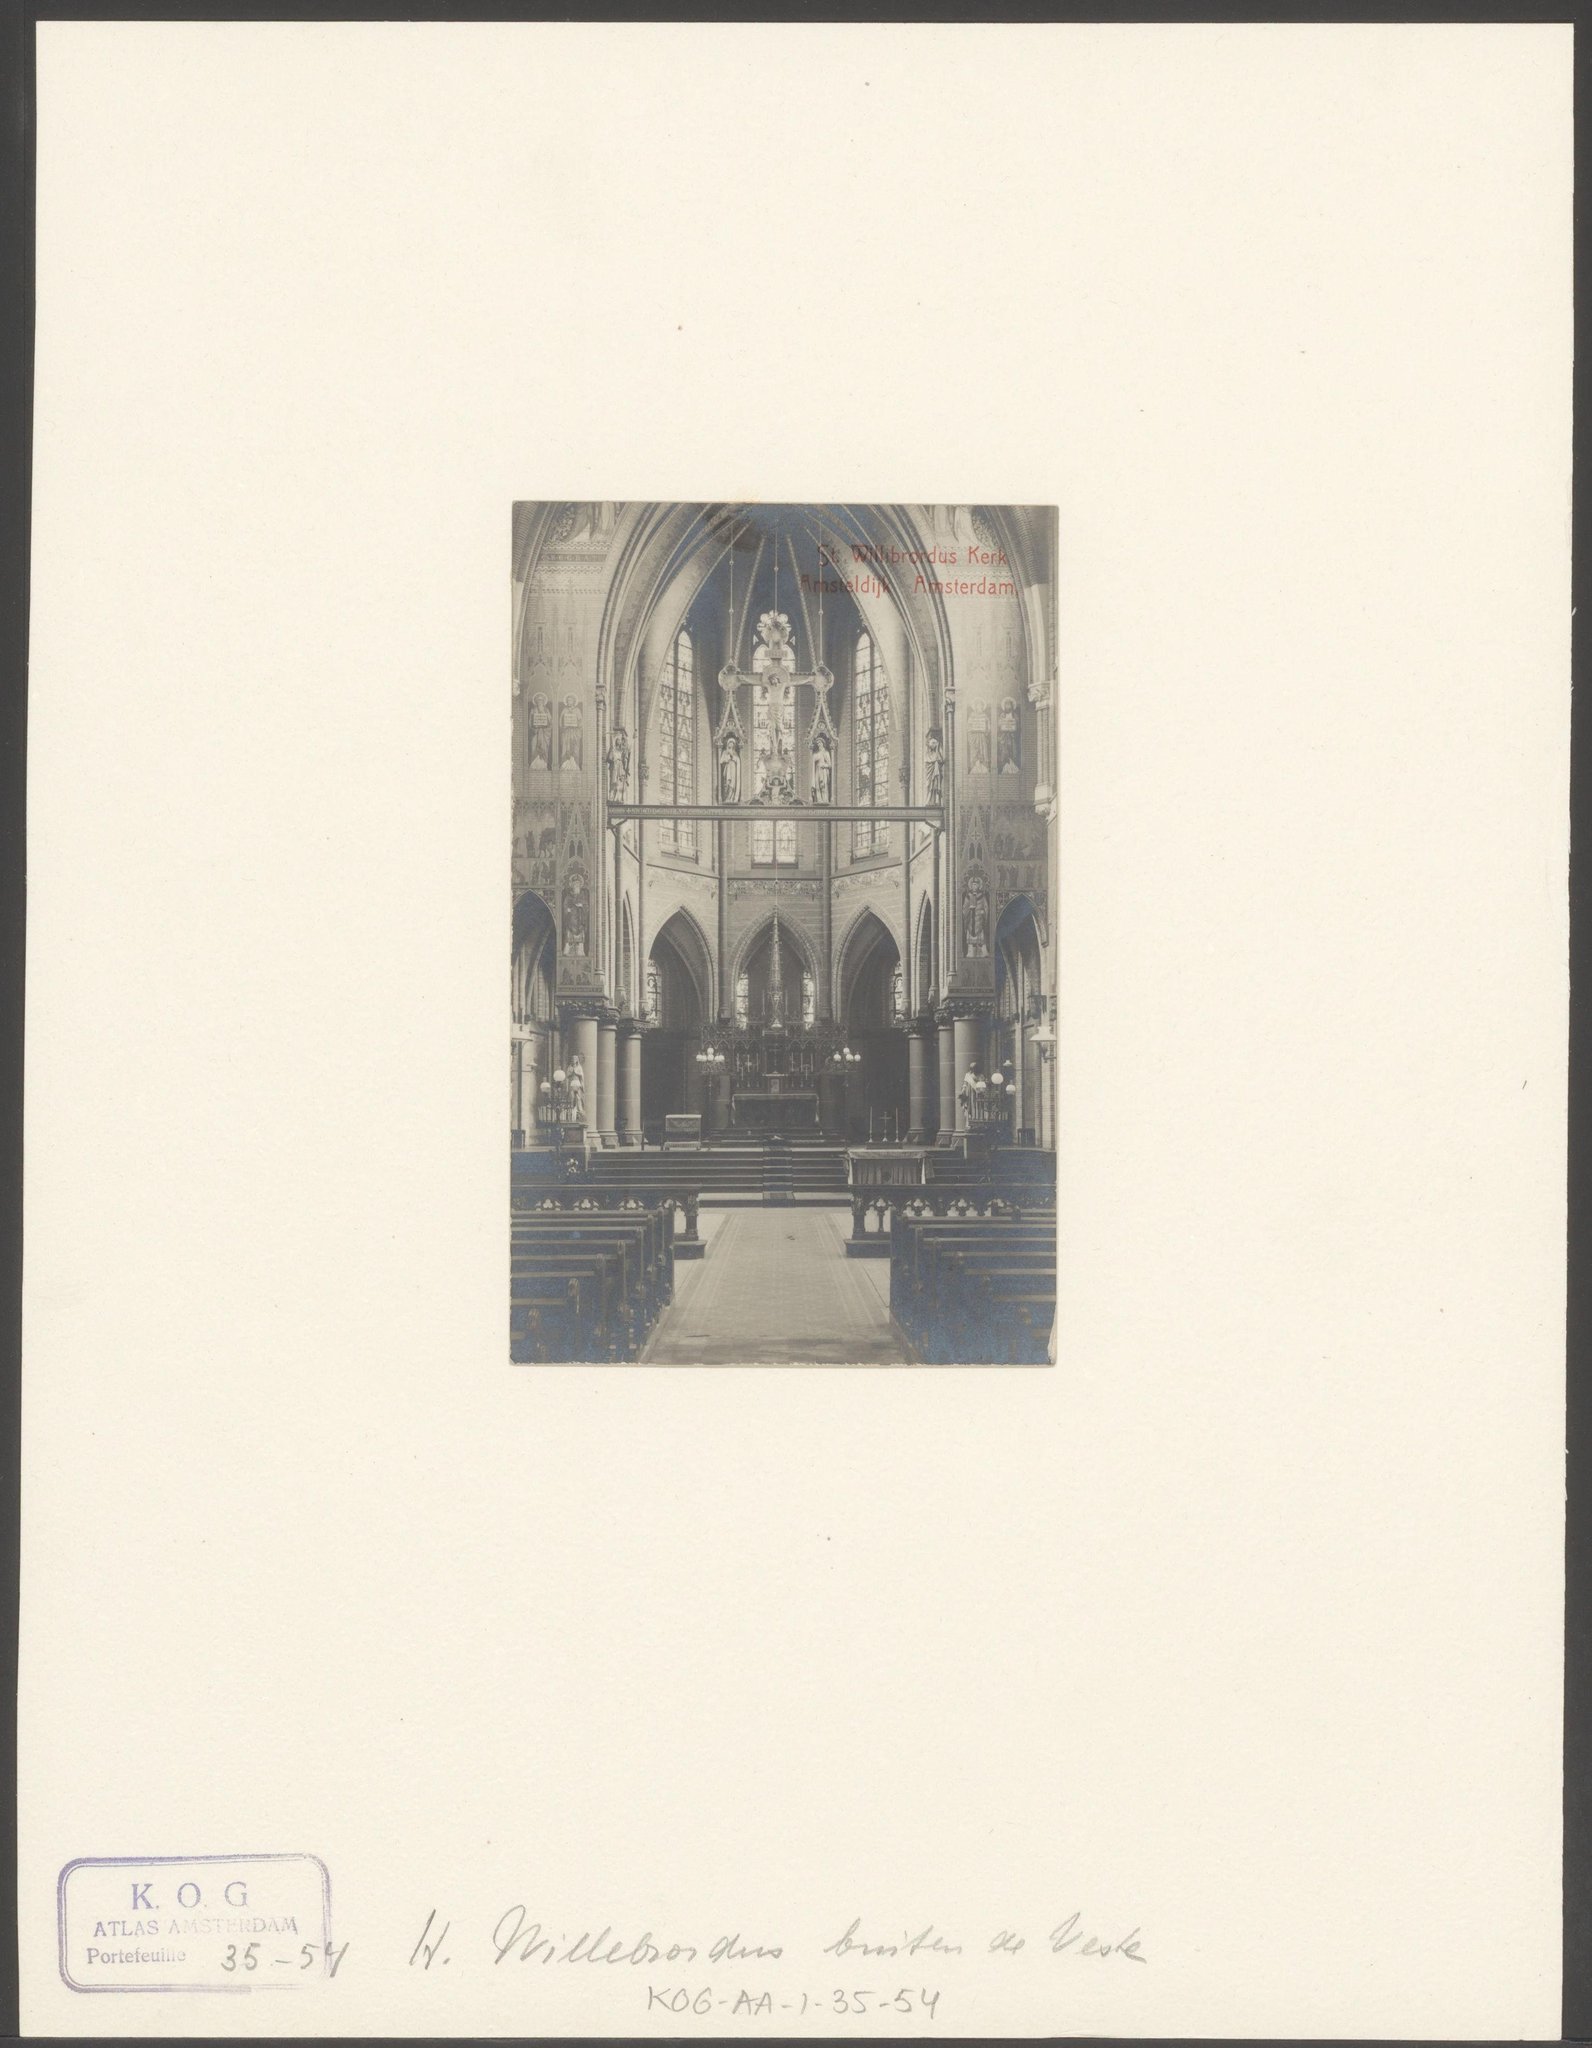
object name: photograph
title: Gezicht op het altaar van de Sint-Willibrorduskerk buiten de Veste (1873-1966) te Amsterdam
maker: Anonymous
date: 1900-1930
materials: paper, cardboard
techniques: gelatin silver print, letterpress printing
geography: amsterdam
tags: parts of church interior: aisle, roman catholic church, fixed altar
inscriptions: collector's mark: ‘17’ Lugt 1641b, collector's mark: ‘35-54’ Lugt 1641b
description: Onderwerpsrubriek binnen de Atlas Amsterdam: R.K. Gemeenten: Sint Nicolaaskerk t/m Willibrordus (Rustenburgerstraat).